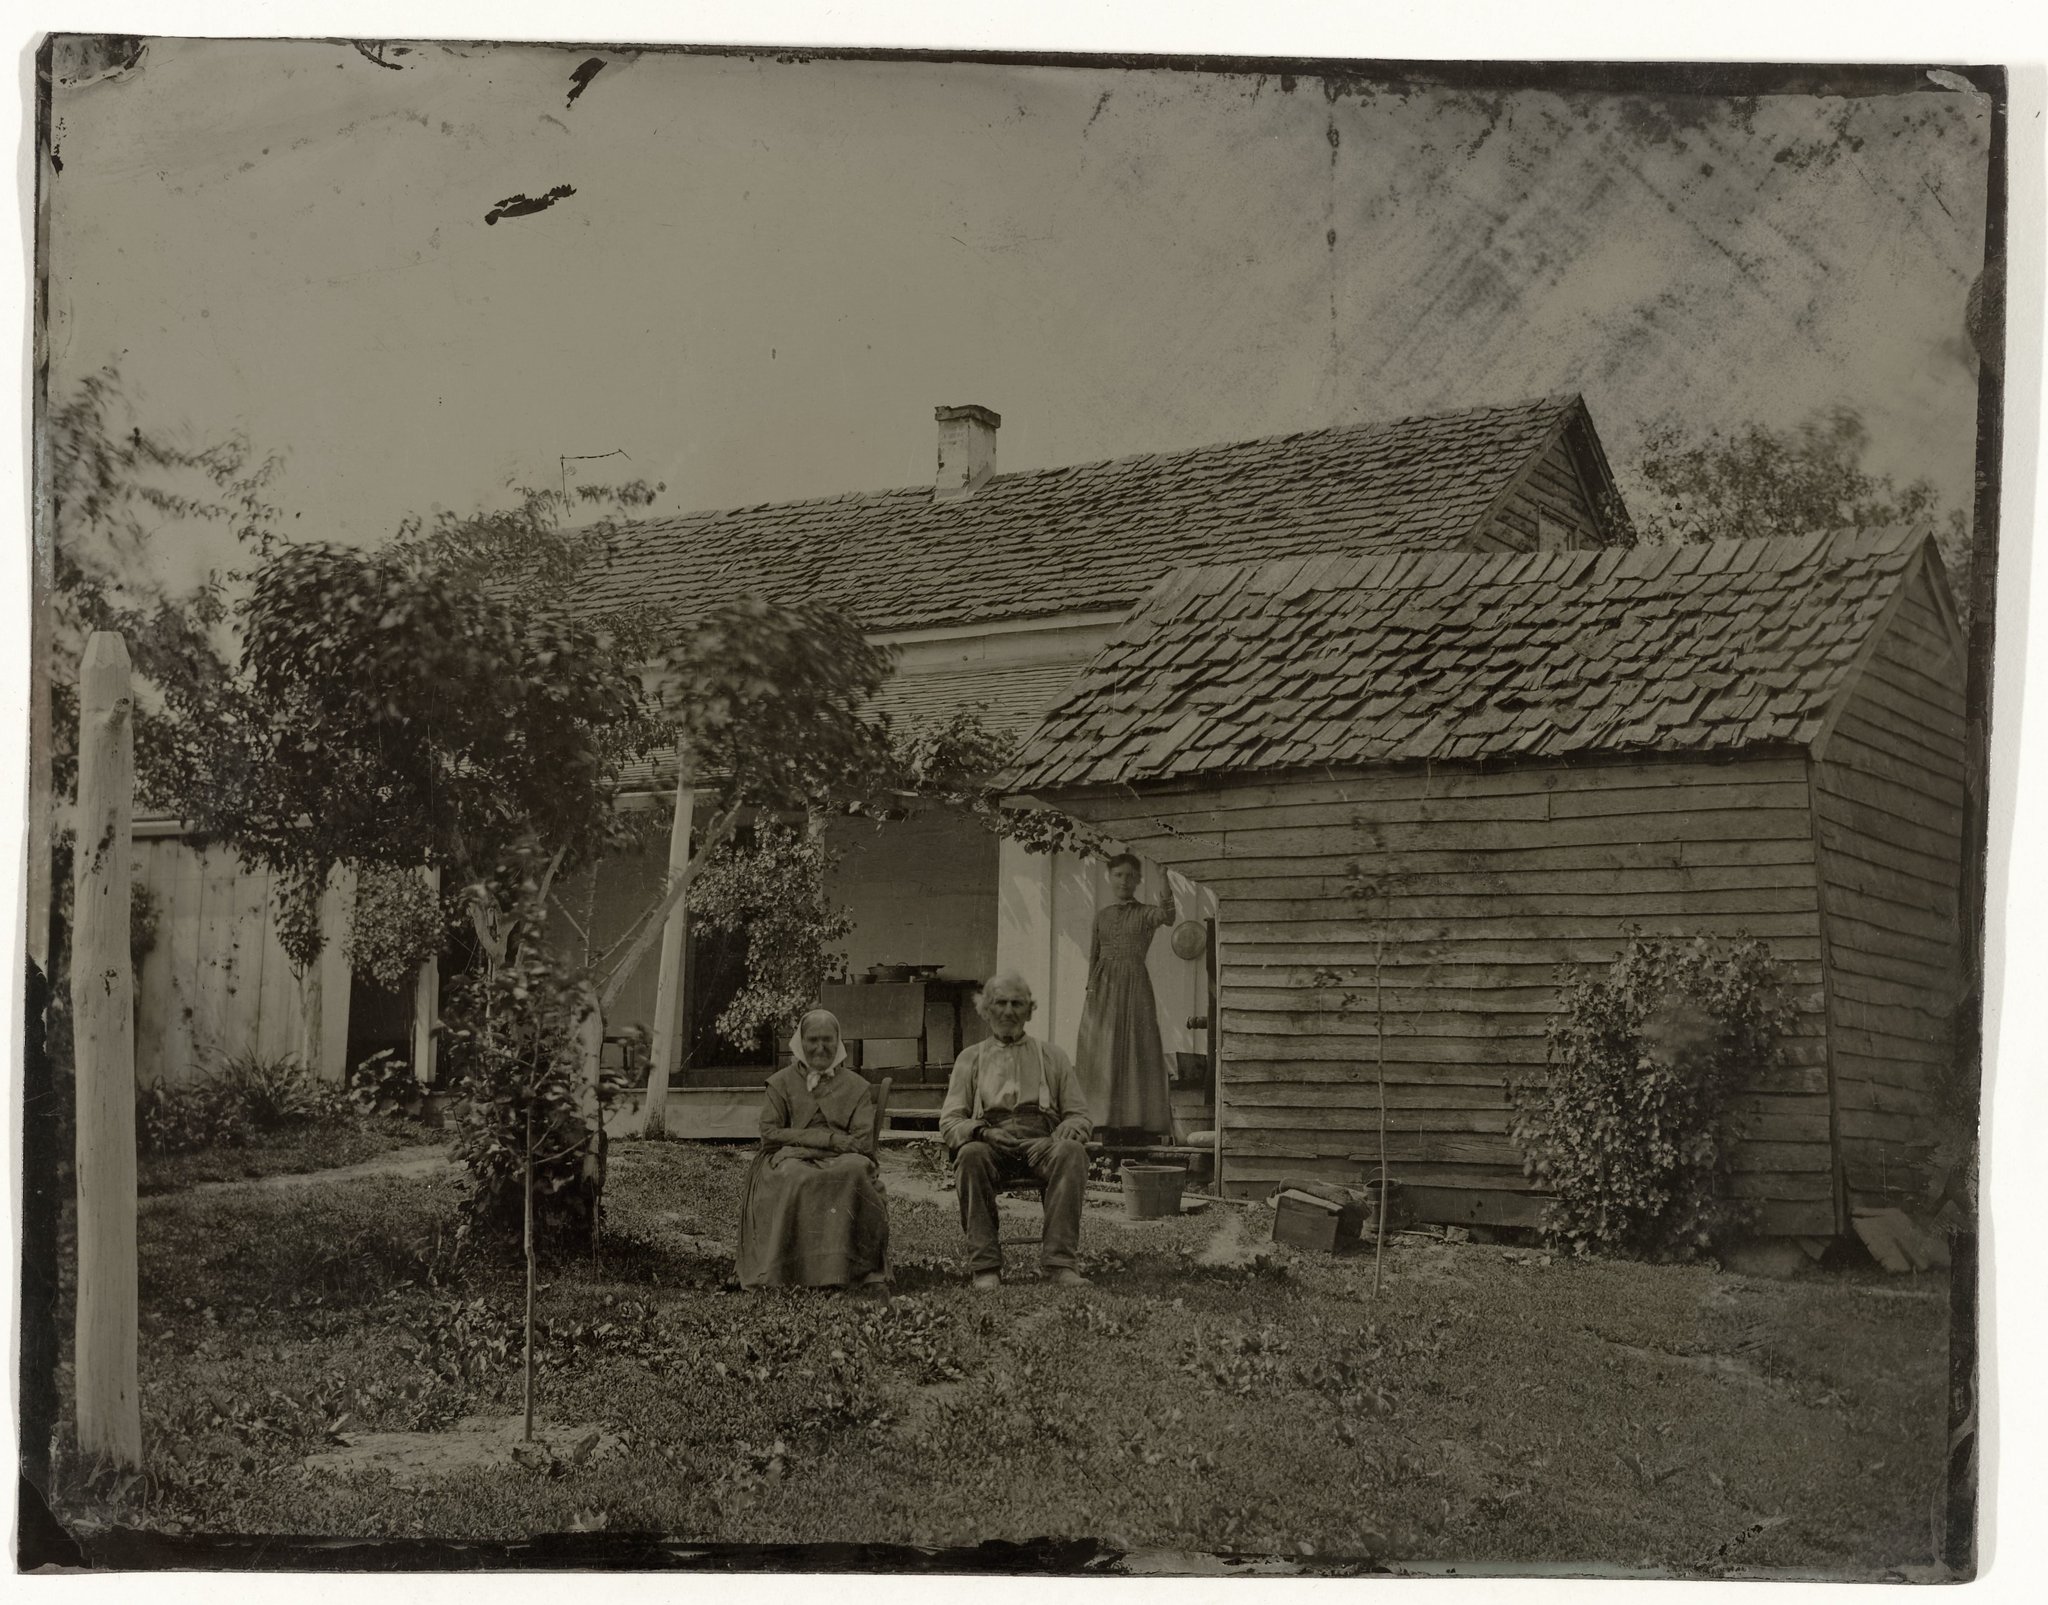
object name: photograph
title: Houten huis met drie bewoners, Verenigde Staten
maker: Anonymous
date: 1870-1900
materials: metal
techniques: ferrotyping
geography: united states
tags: rural housing, e.g. country-house, villa, cottage, united states of america